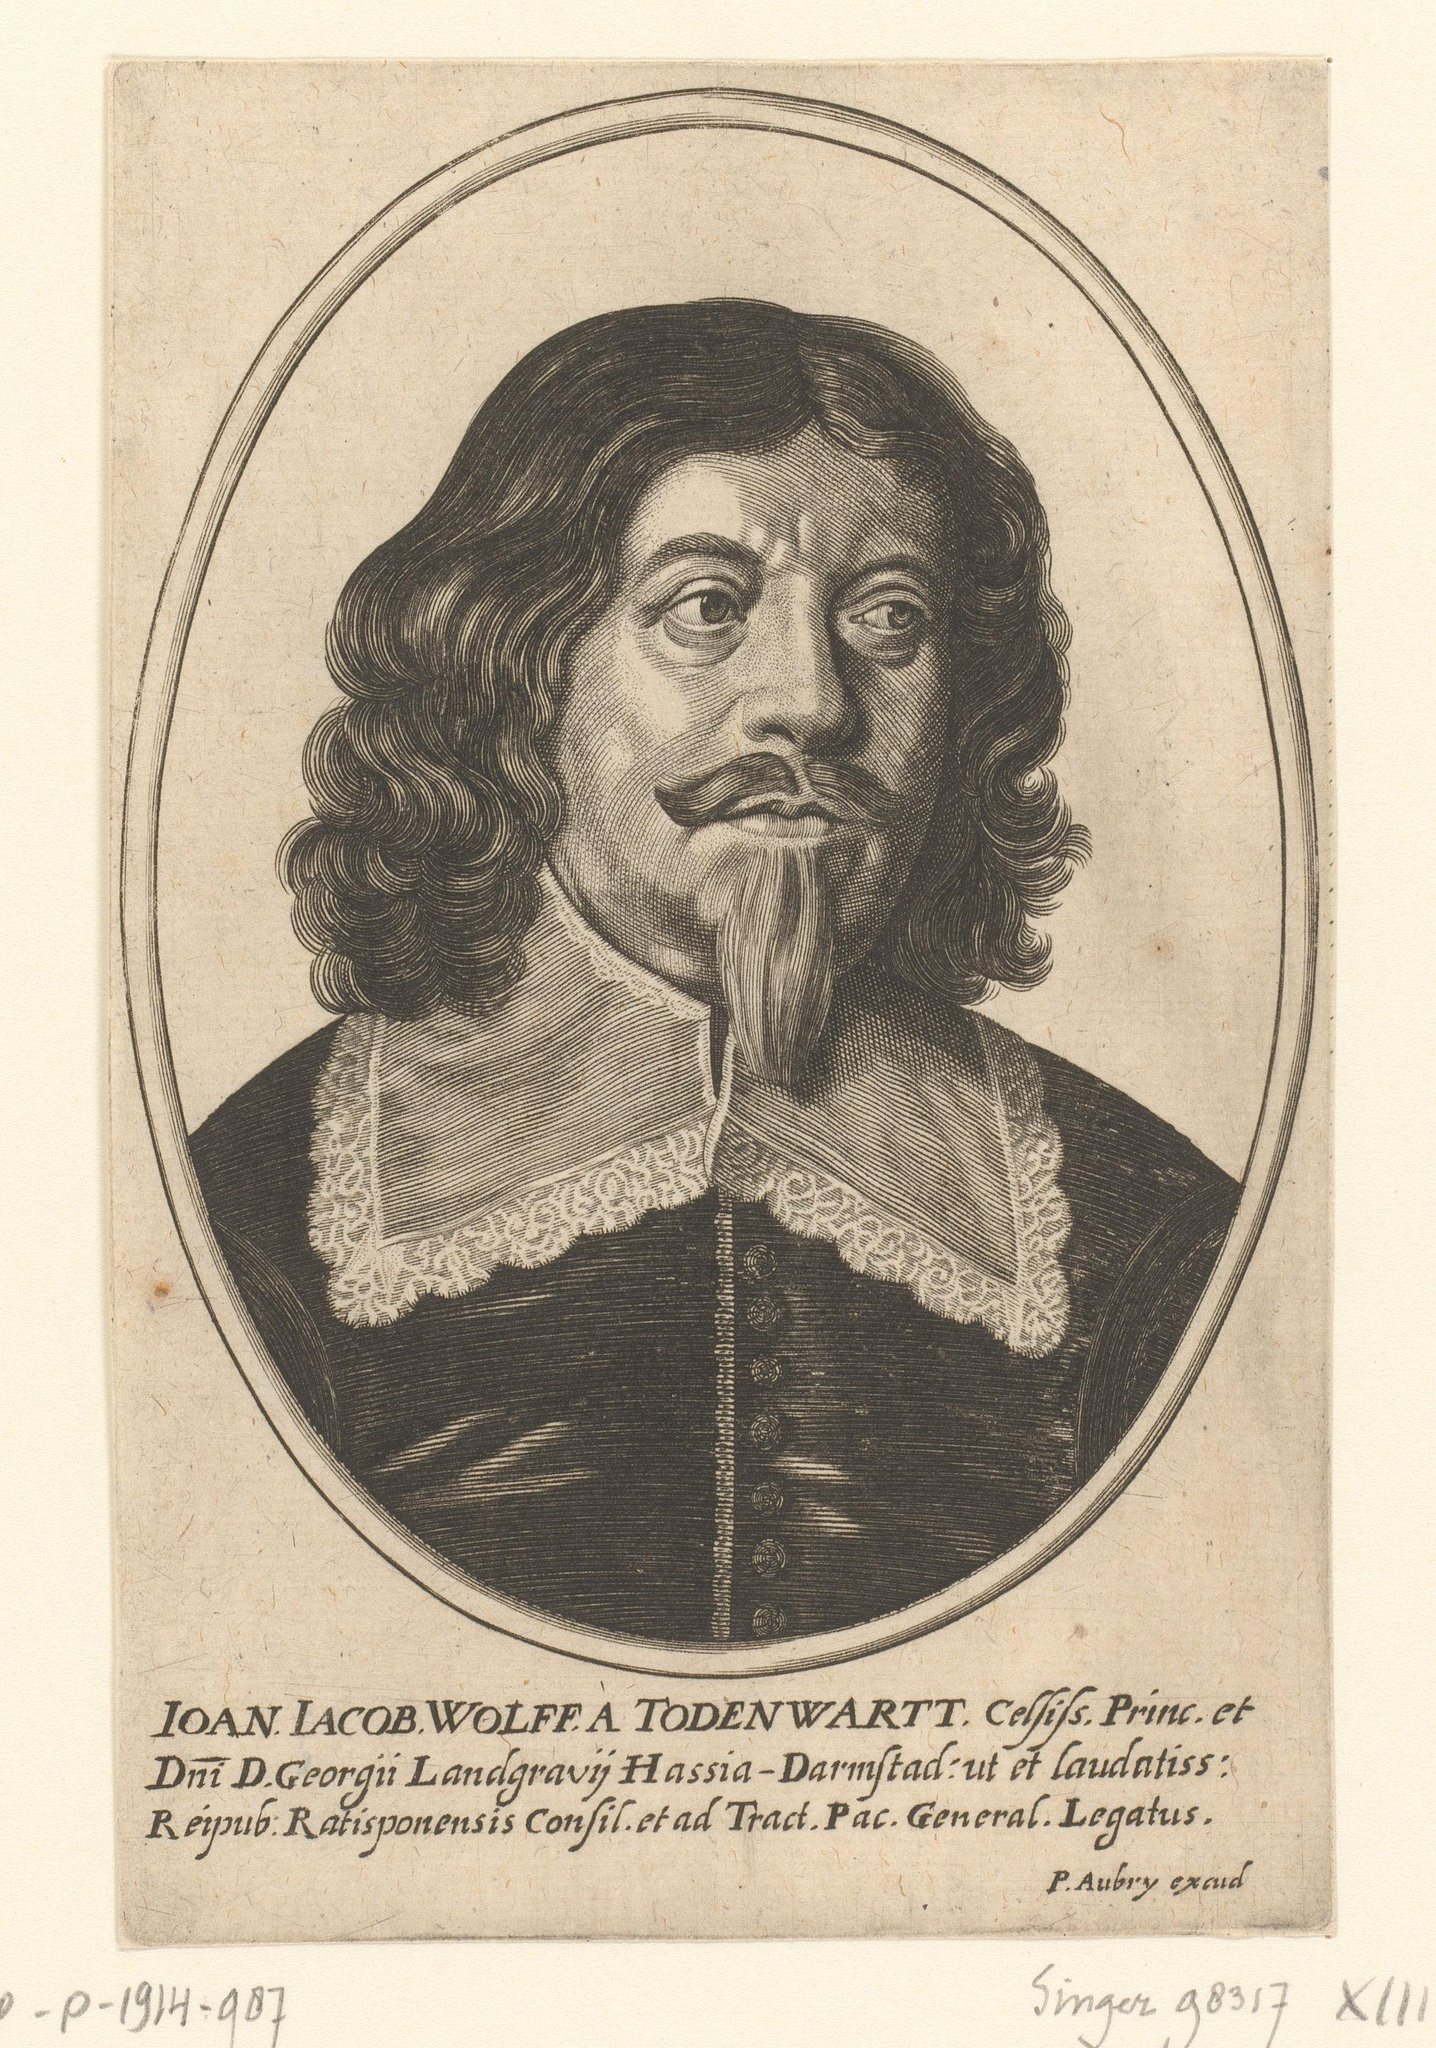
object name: print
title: Portretten van afgevaardigden bij de Vrede van Westfalen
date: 1648-1650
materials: paper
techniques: engraving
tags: governmental and representative bodies, historical persons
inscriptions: collector's mark: Lugt 2228